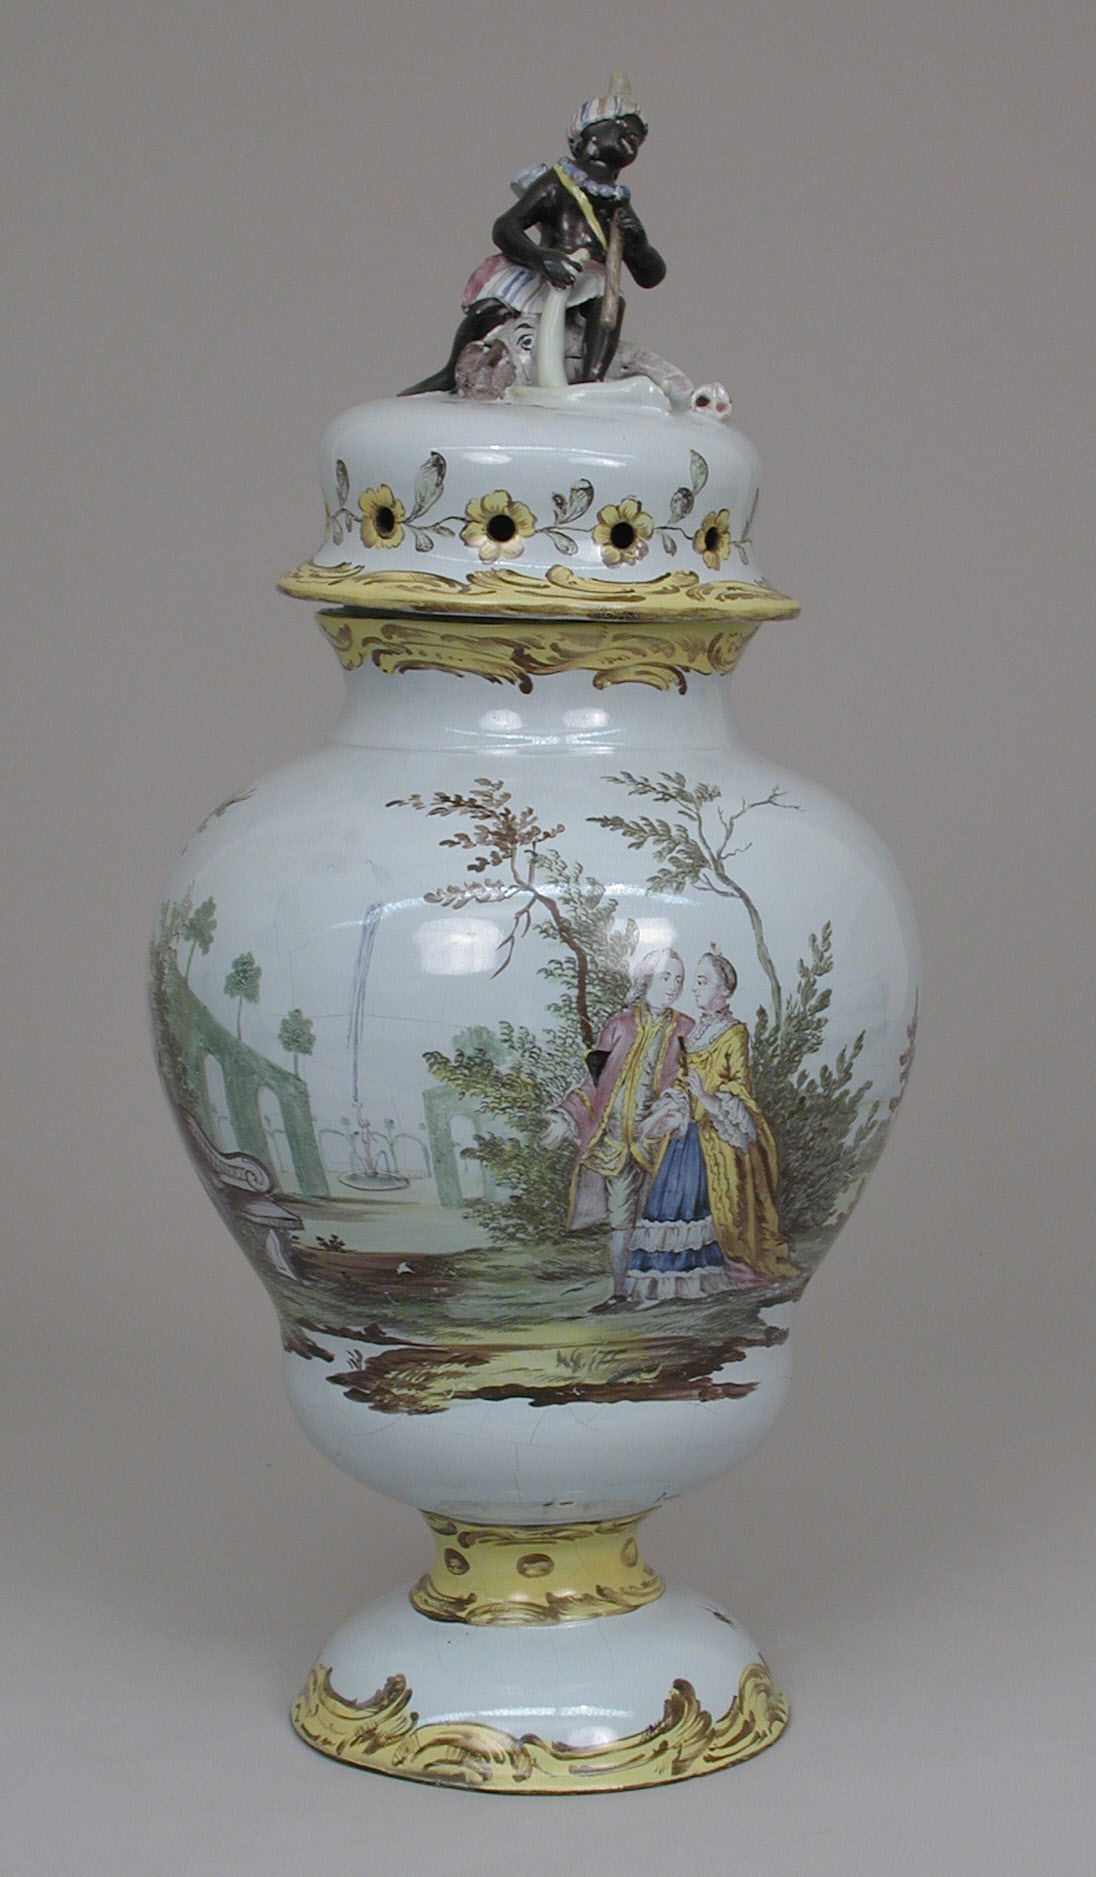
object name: potpourri vase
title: Potpourri vase with cover (one of a pair)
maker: abraham leihamer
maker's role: artist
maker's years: 1745-1774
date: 1772-1774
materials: earthenware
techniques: glazing